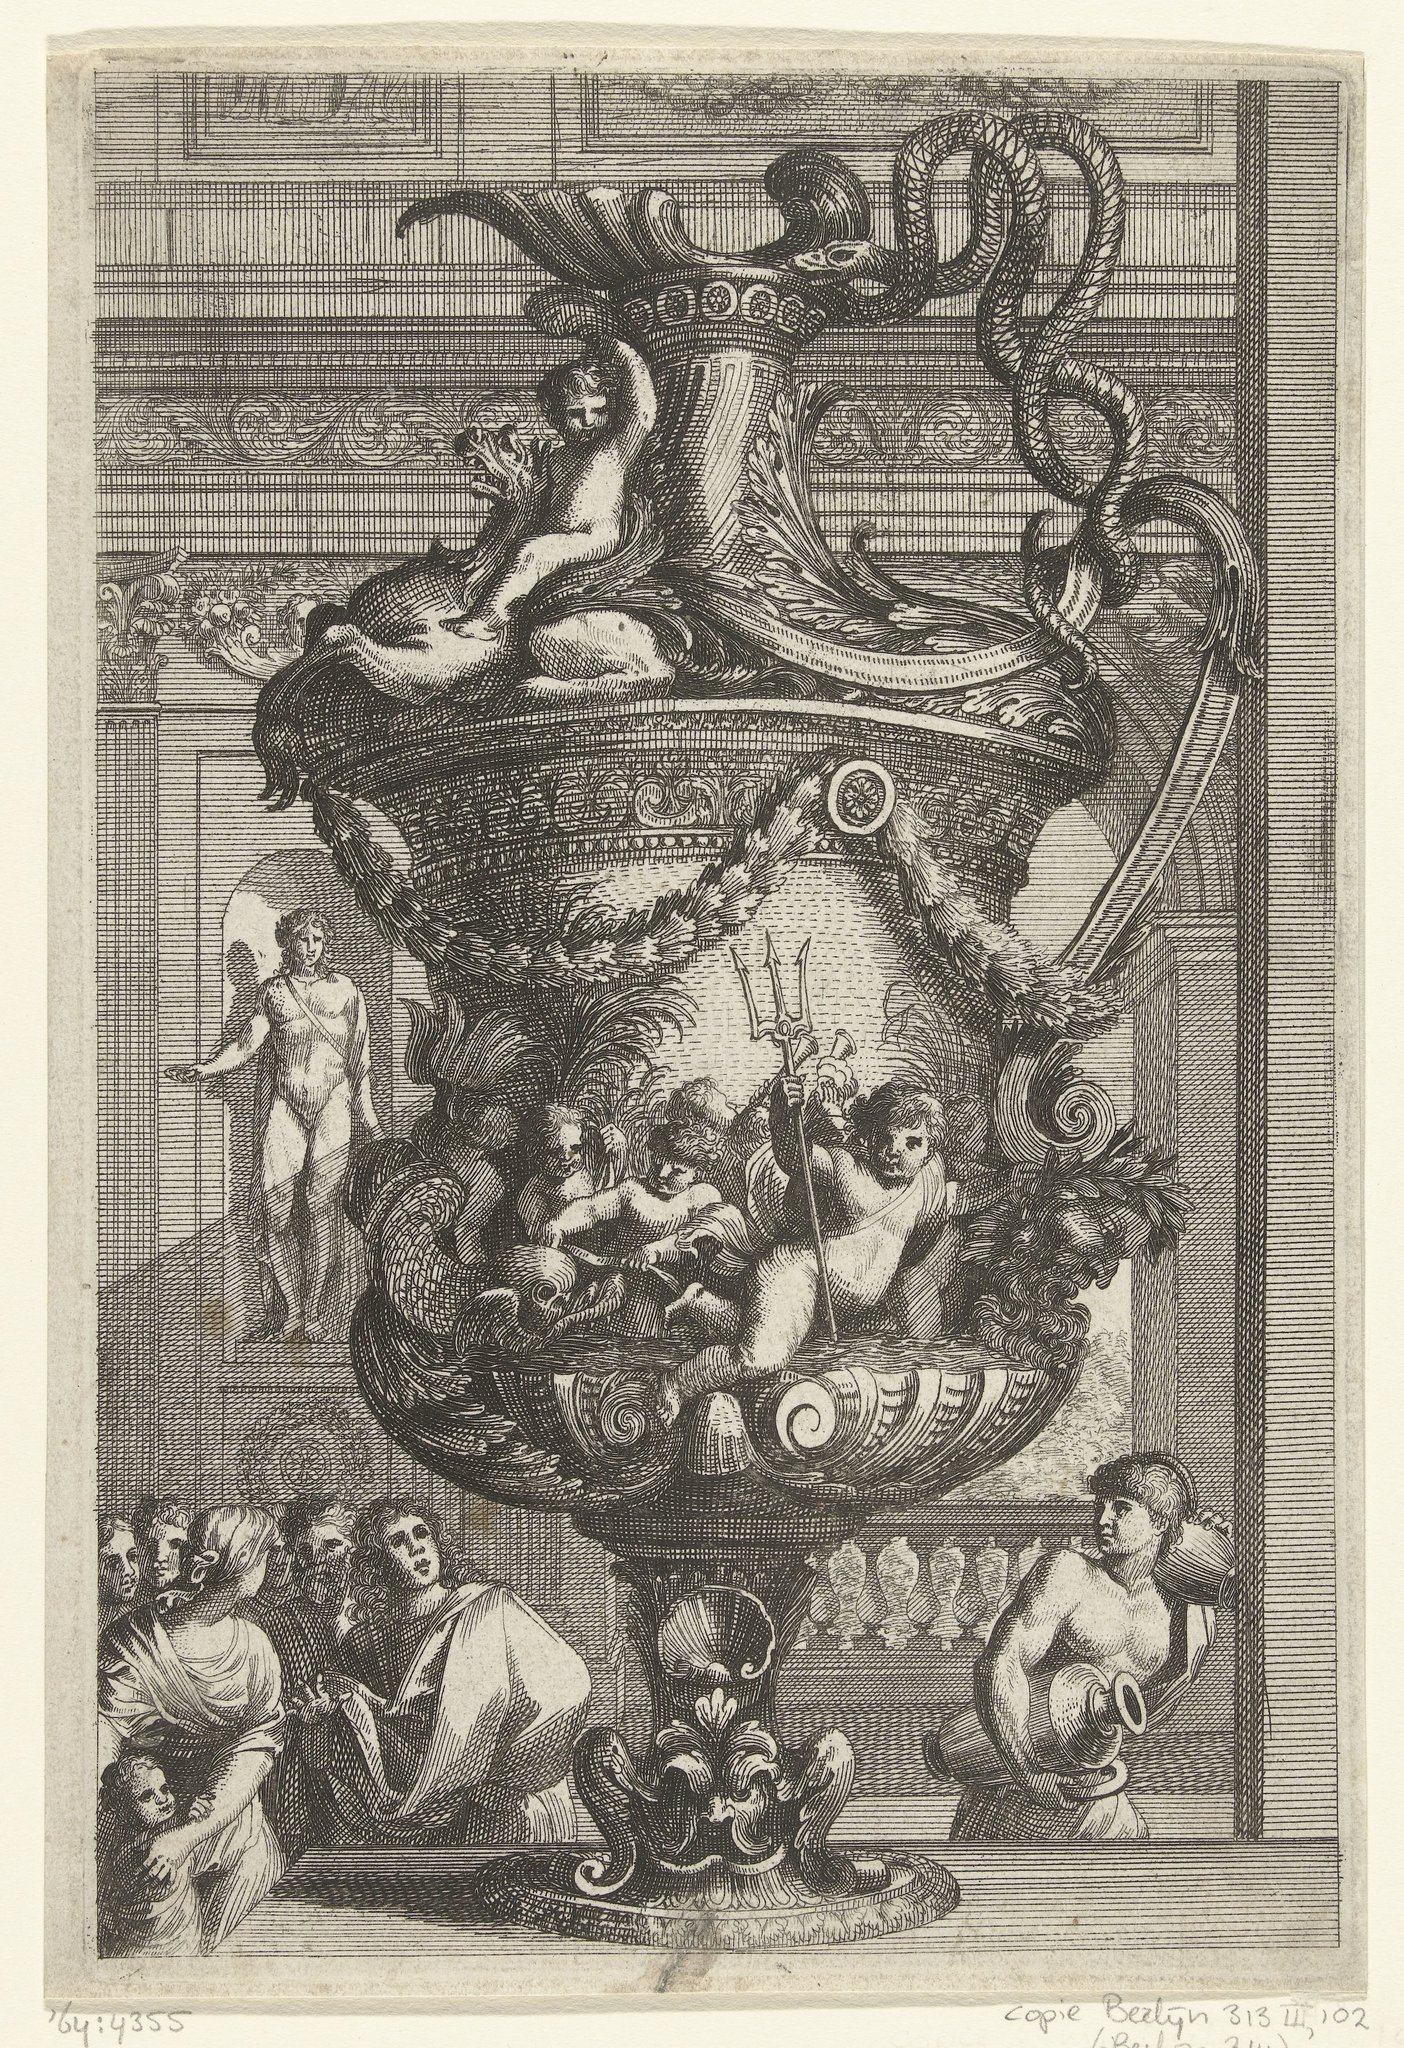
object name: print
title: Vasi fatti al moderno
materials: paper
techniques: etching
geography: france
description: De kan heeft een handvat in de vorm van twee slangen, op het lichaam spelen kinderen met een dolfijntje.